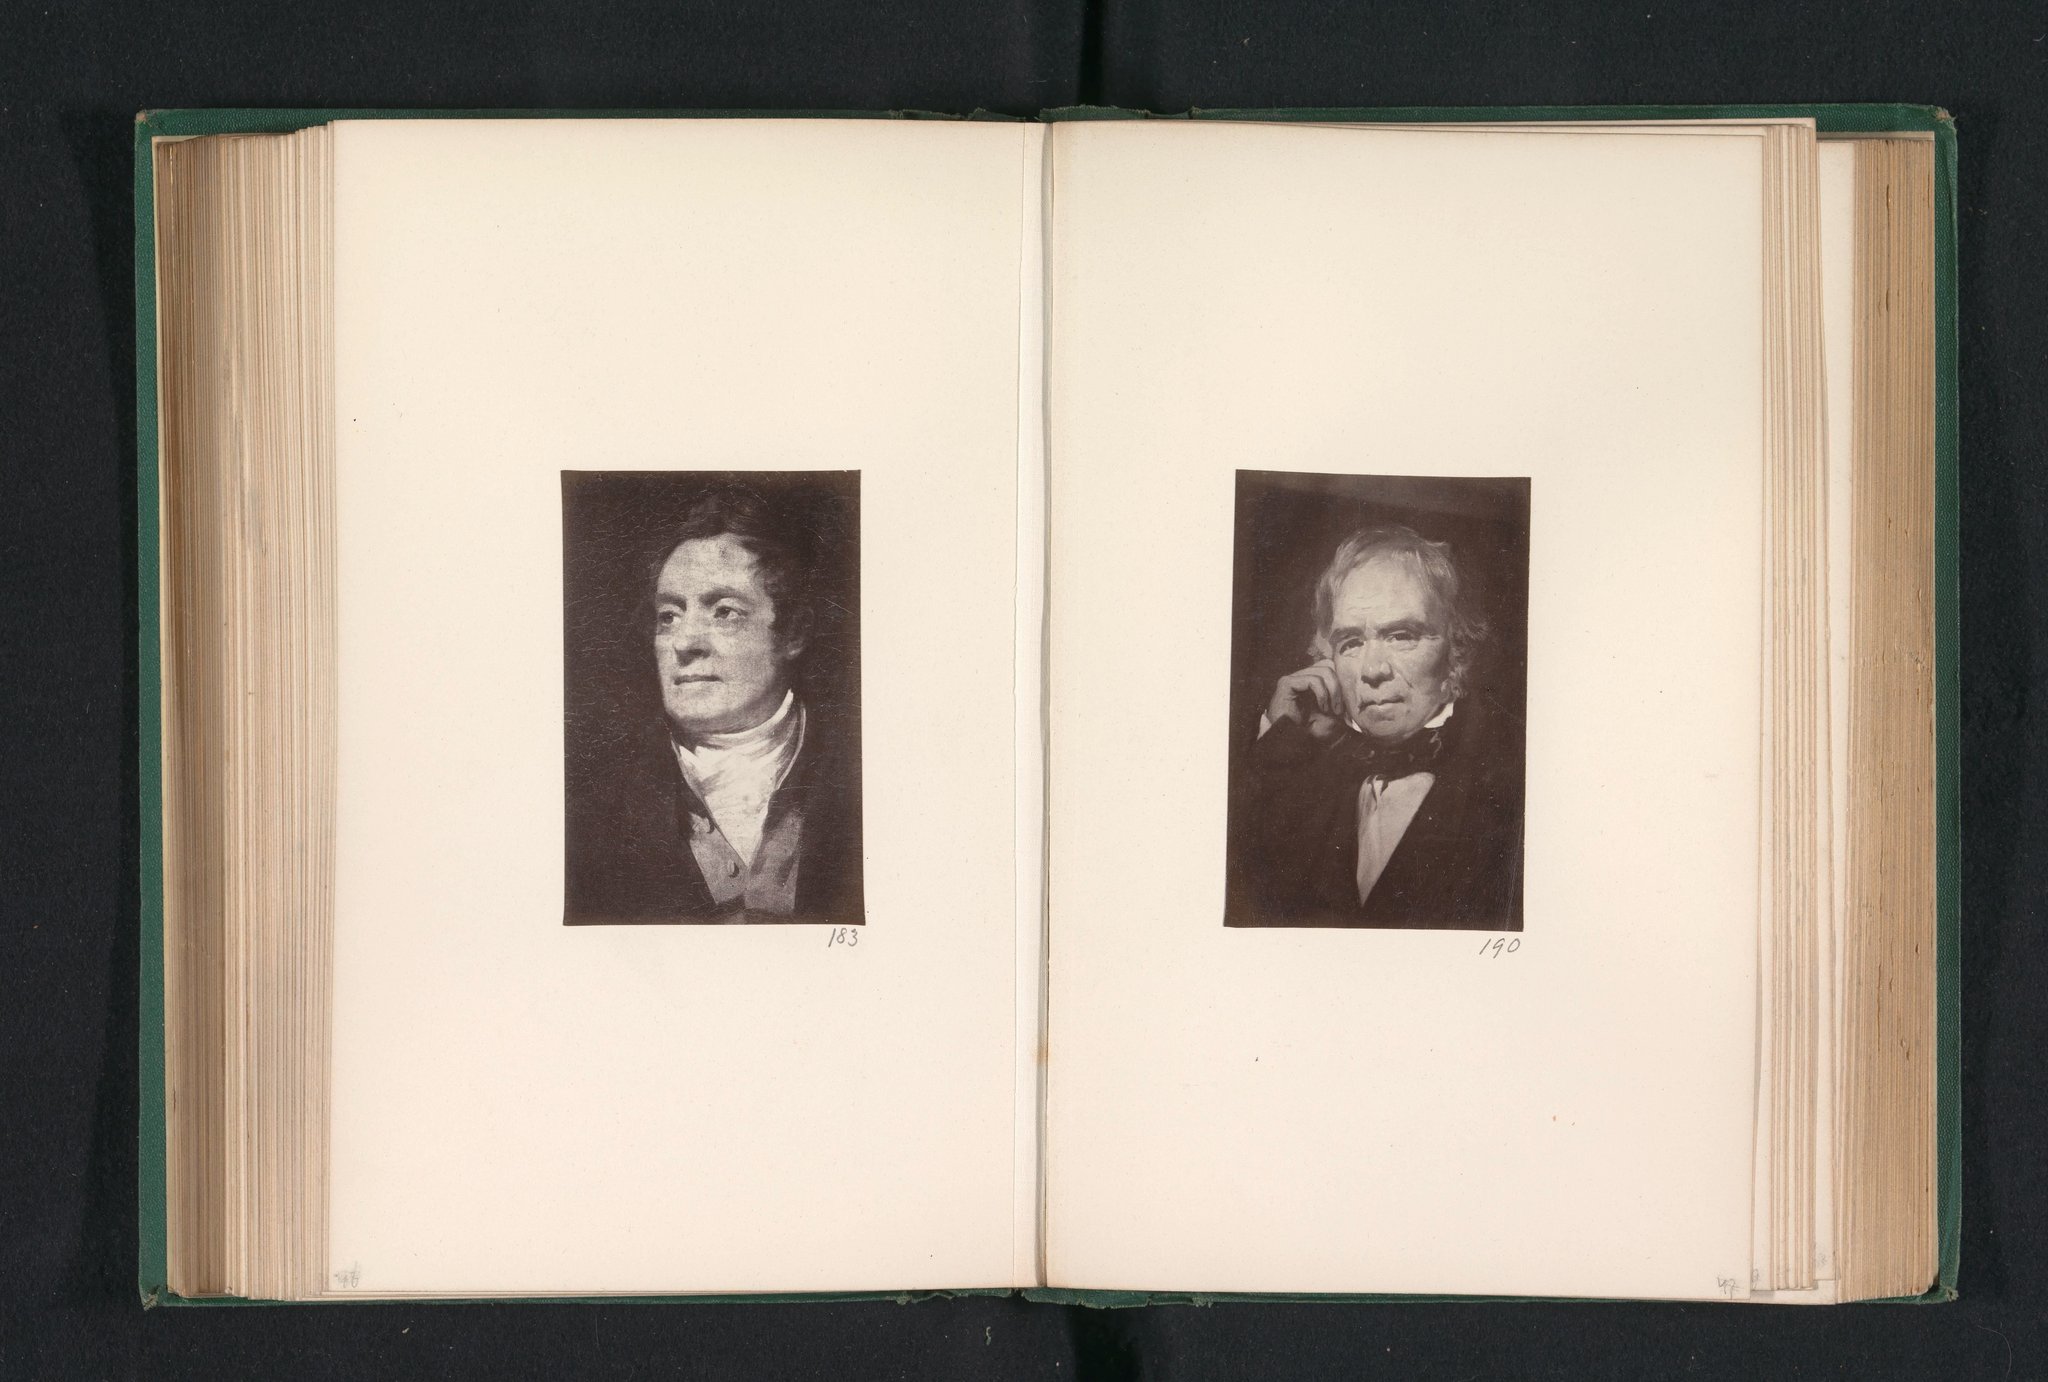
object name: page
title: Fotoreproductie van een schilderij, voorstellende een portret van Henry Houldsworth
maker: thomas annan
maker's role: fotograaf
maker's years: 1829-1887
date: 1863-1868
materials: photographic support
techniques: albumen print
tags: historical persons (portraits and scenes from the life) (+ (full) bust portrait)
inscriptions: number: ‘190’